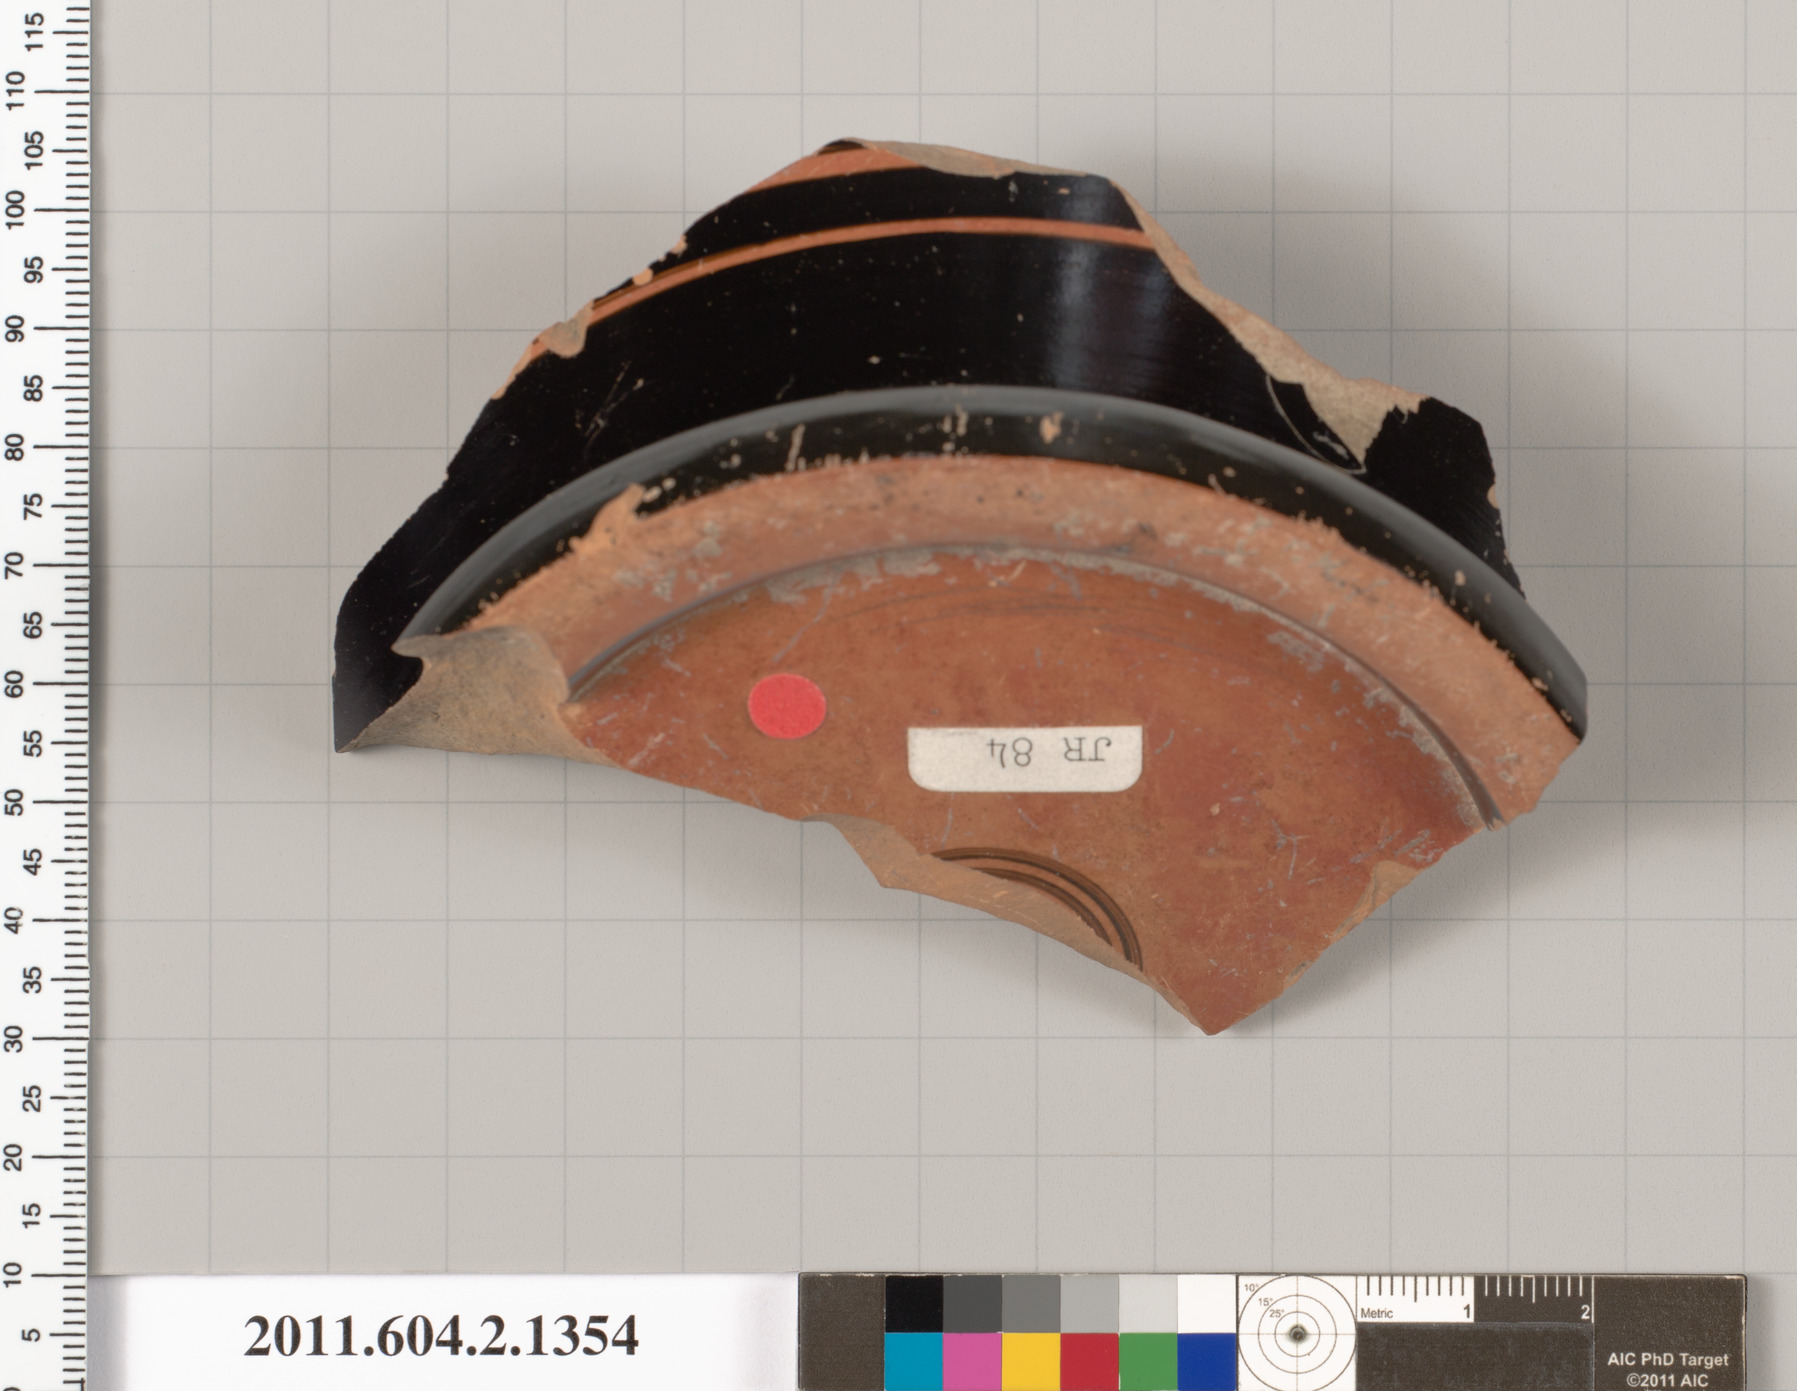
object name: skyphos fragment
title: Terracotta fragment of a skyphos (deep drinking cup)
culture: greek, attic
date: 475-451 BCE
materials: terracotta